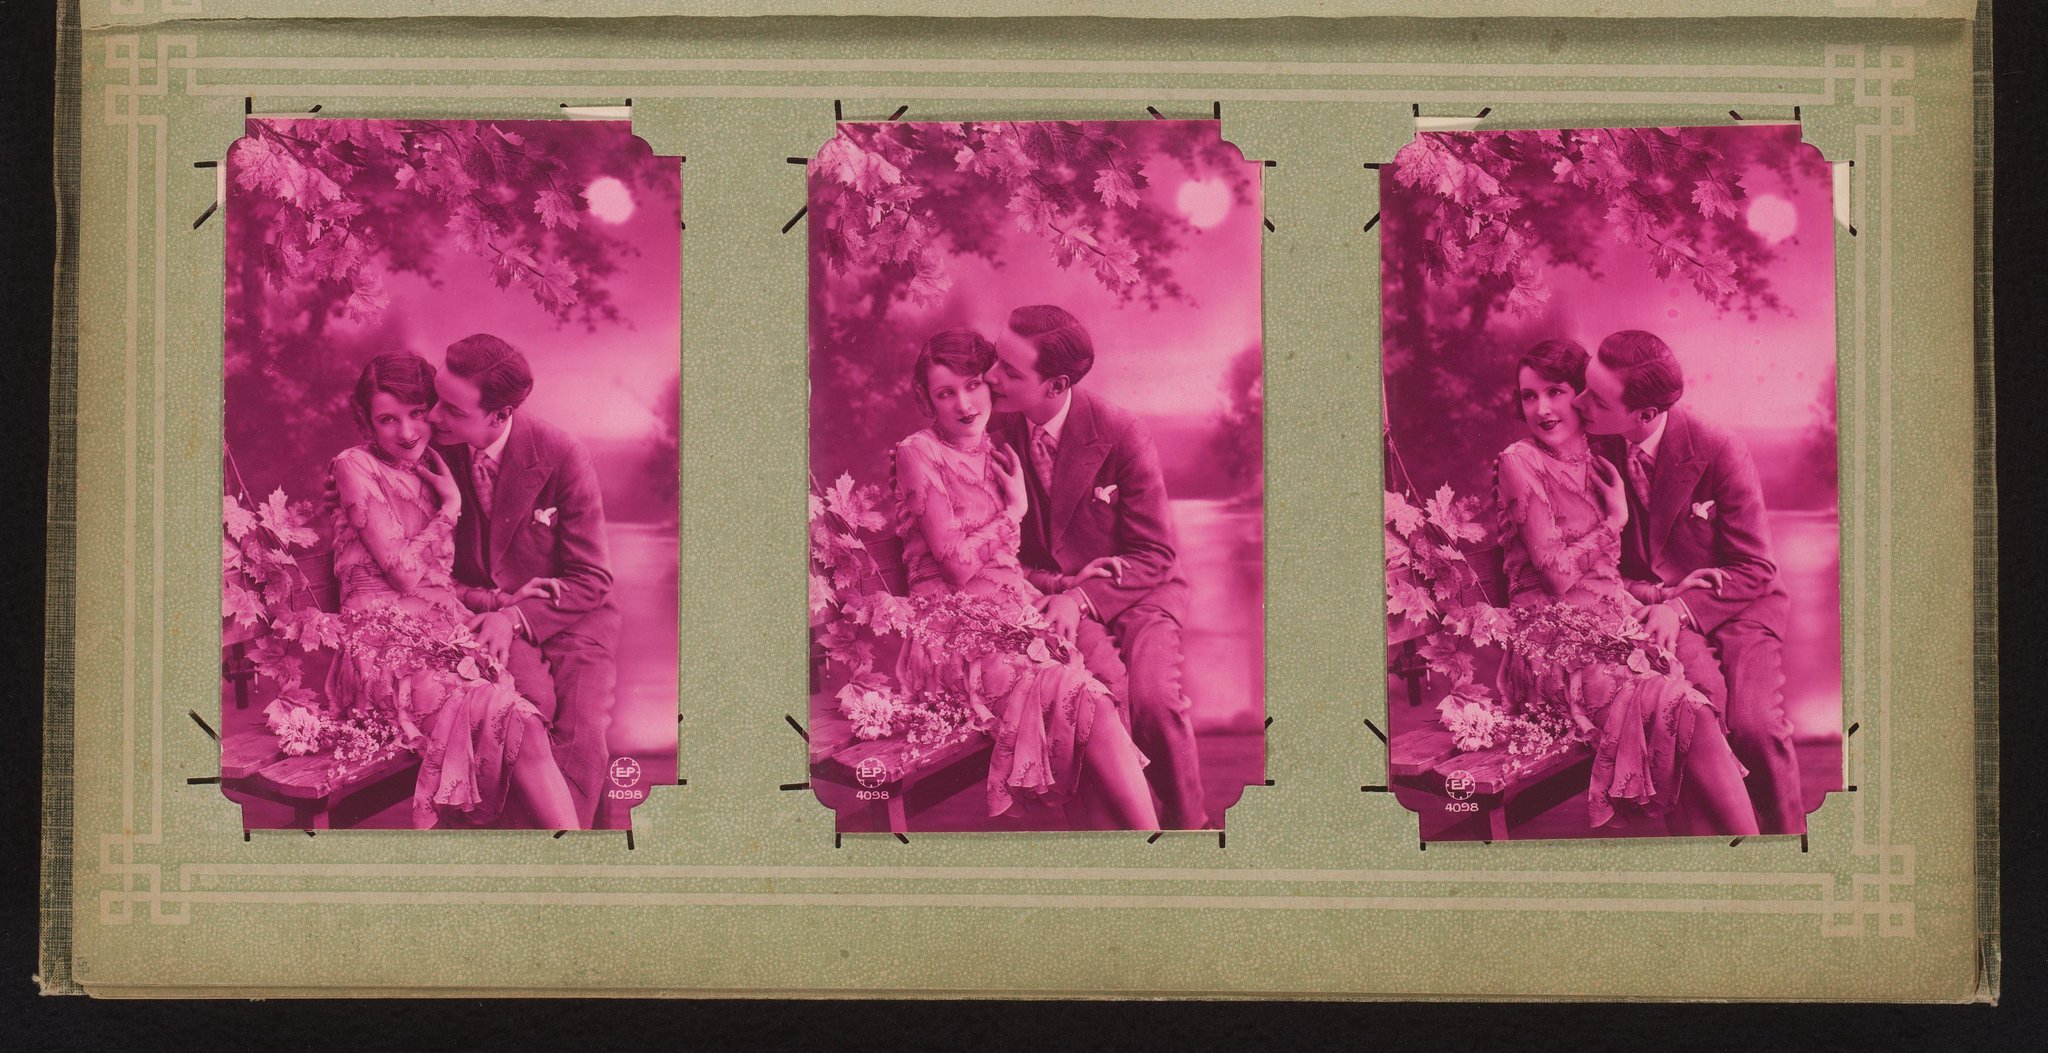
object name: ansichtkaart, prentbriefkaart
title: Drie portretten van een paar geliefden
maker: Anonymous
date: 1900-1930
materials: cardboard, photographic support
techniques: gelatin silver print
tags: historical persons - bb - woman, historical persons, couple of lovers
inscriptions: monogram: ‘EP’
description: Deze foto's maken deel uit van een album.